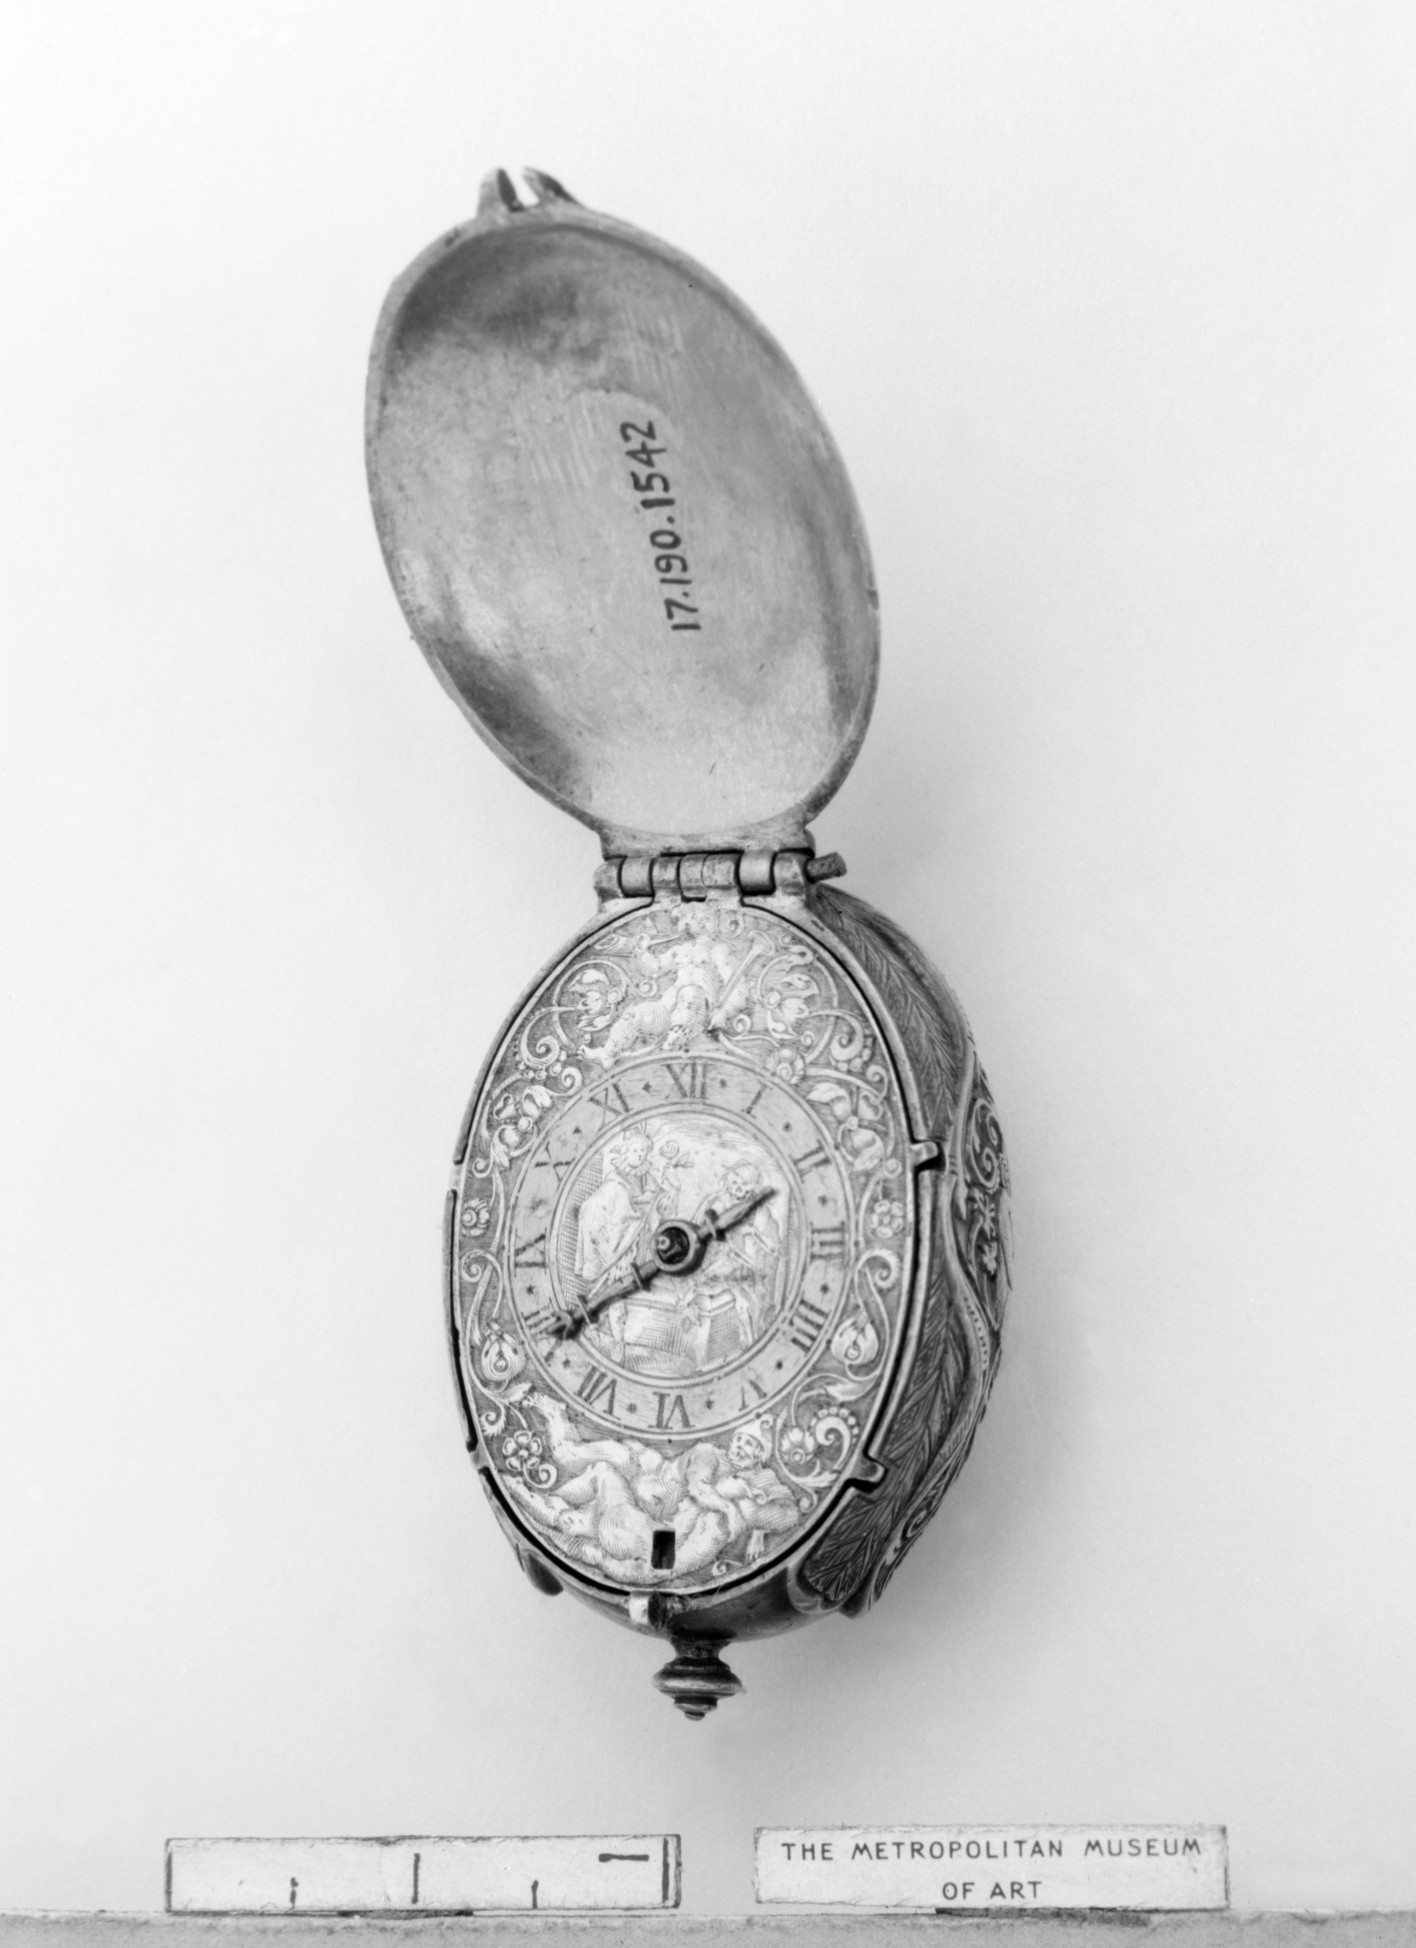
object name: watch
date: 1620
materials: gilt, metal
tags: human figures,horns